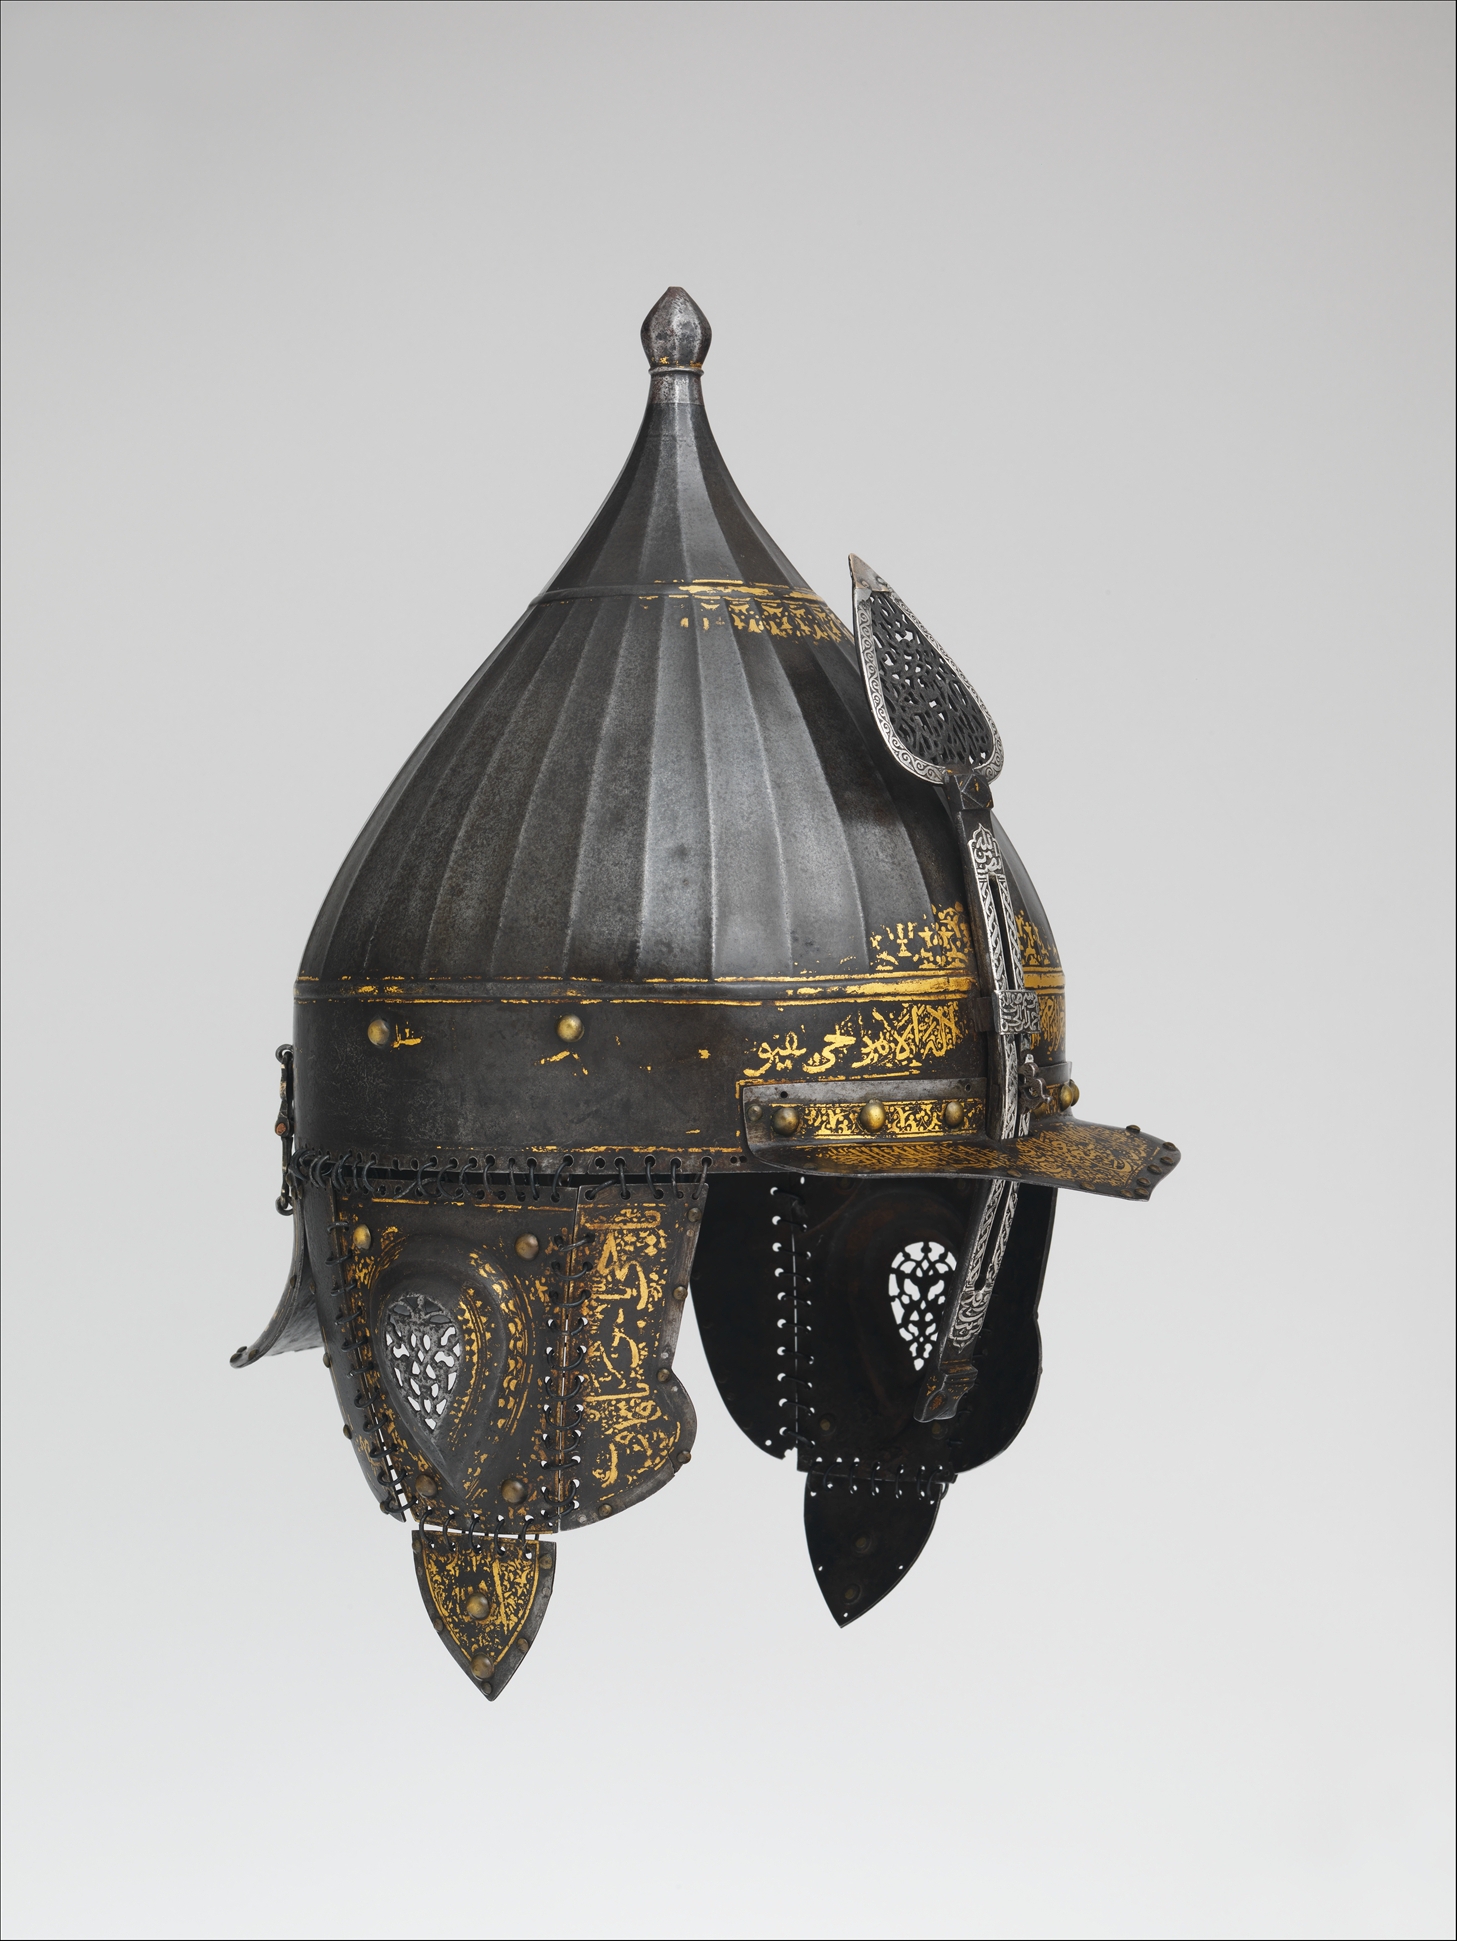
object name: helmet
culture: turkish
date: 1560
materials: copper alloy, gold, iron, silver, steel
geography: turkey